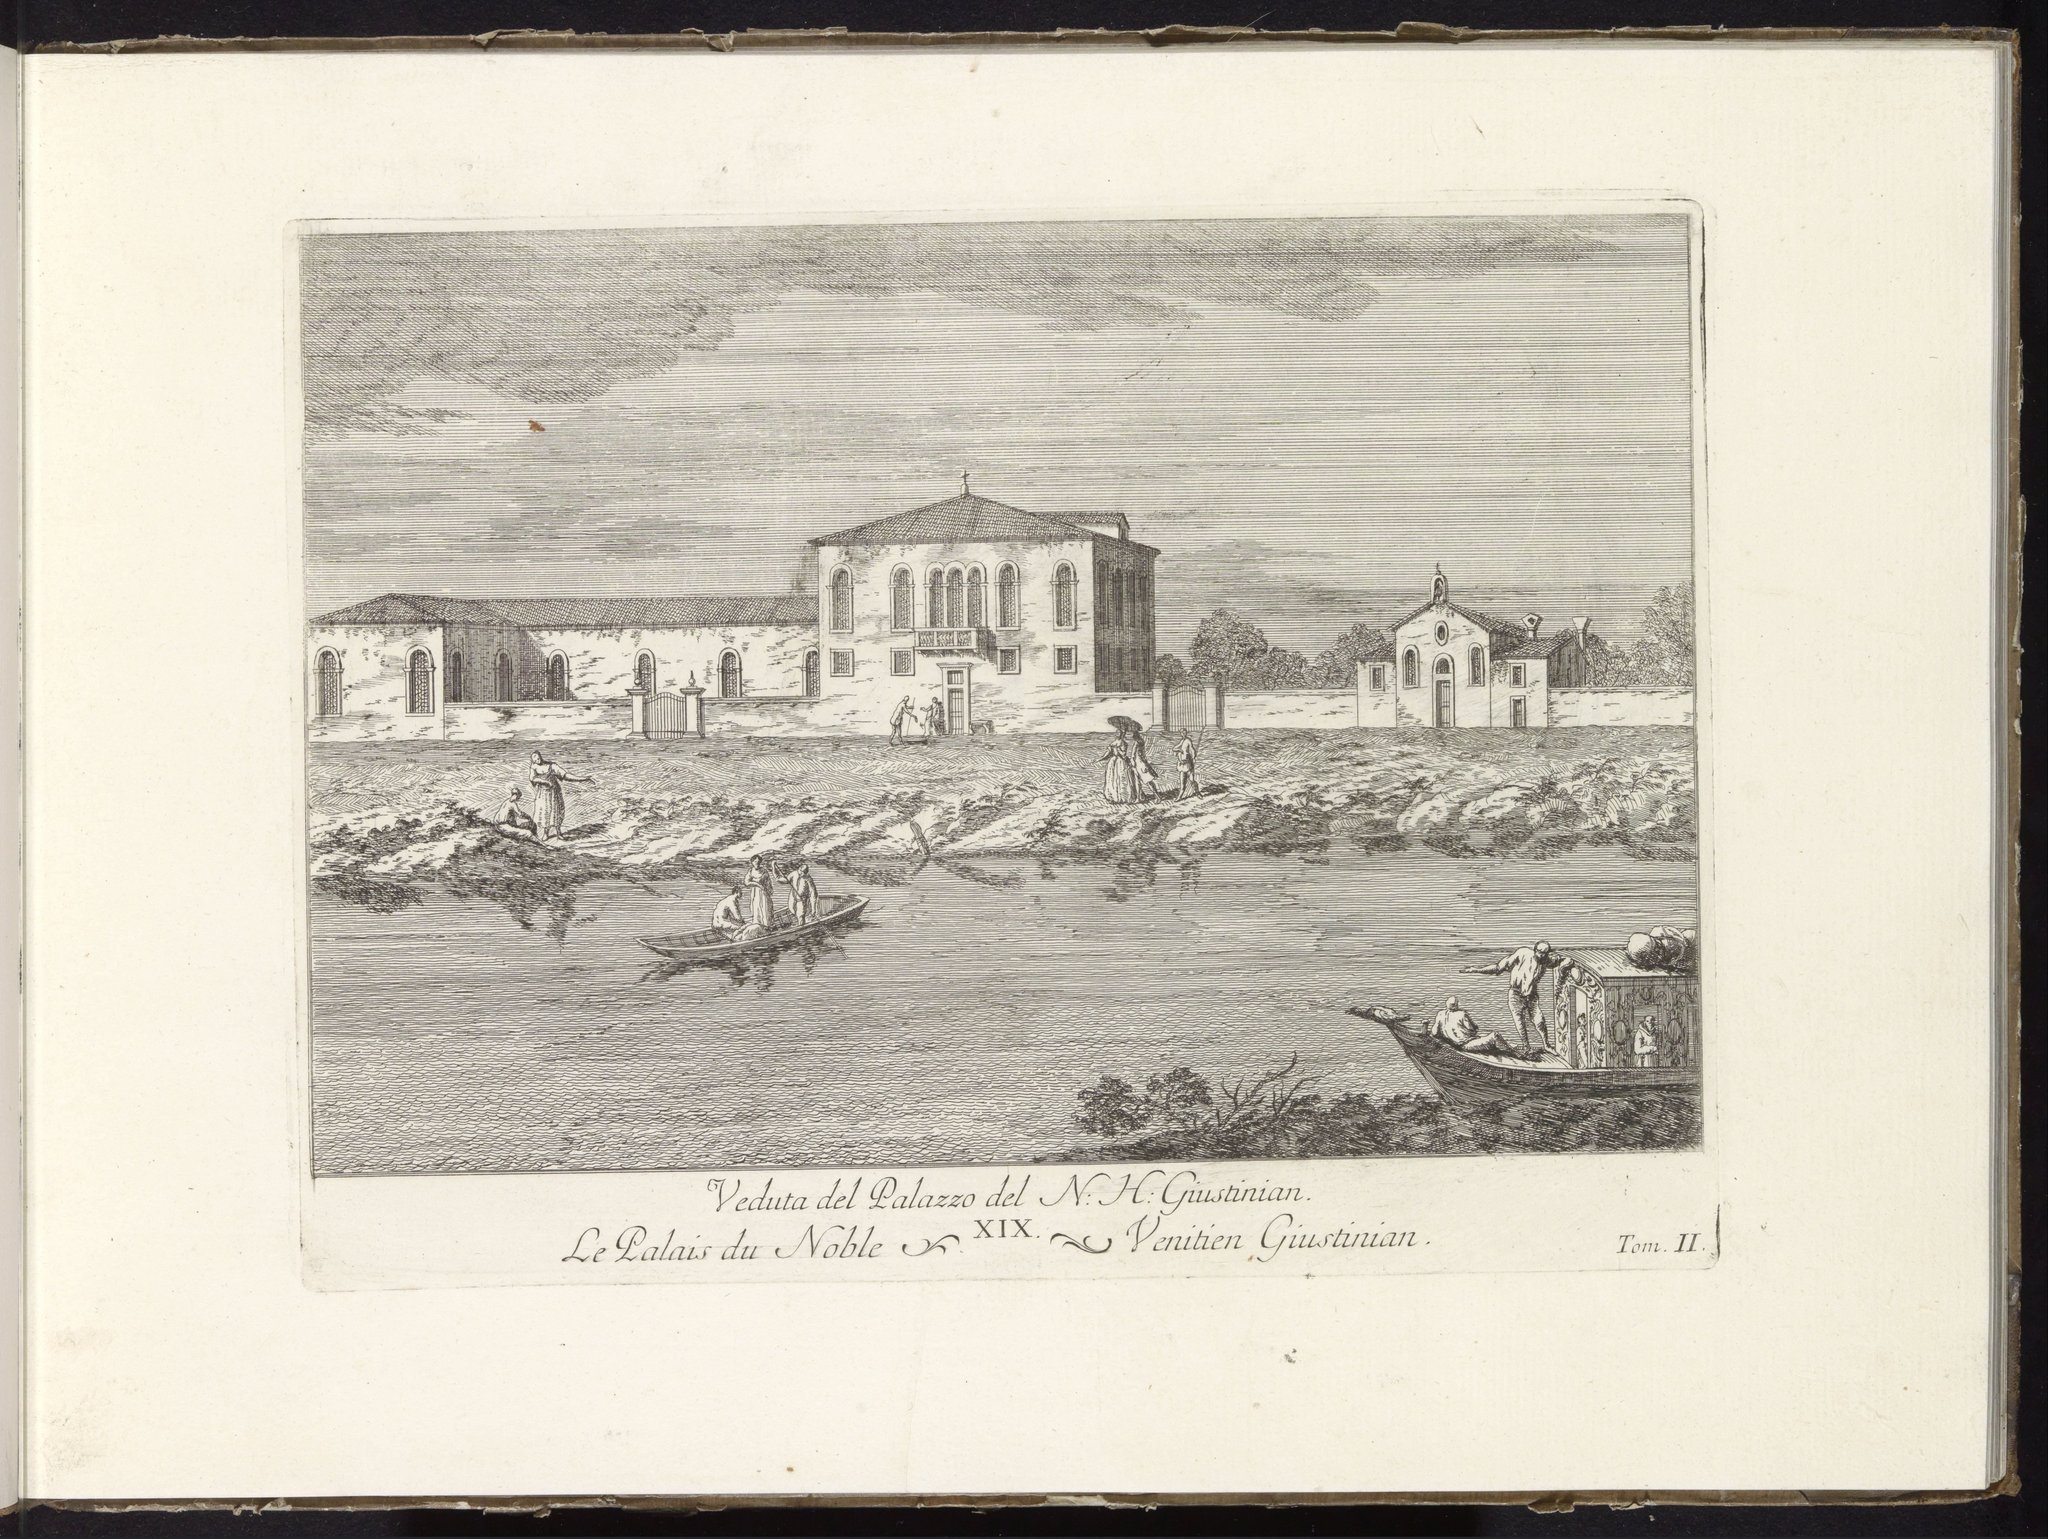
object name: print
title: Les delices de la Brenta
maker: giovanni francesco costa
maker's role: draughtsman, painter, print maker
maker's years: -1773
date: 1750-1760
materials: paper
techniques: etching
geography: italy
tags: river, hôtel, i.e. small palace in city, gondola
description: Gezicht op Palazzo del N: H: Giustinian aan de rivier de Brenta. Op het water een gondel en een roeiboot. Genummerd midden onder: XIX en rechtsonder: Tom: II. Deze prent maakt deel uit van een album.